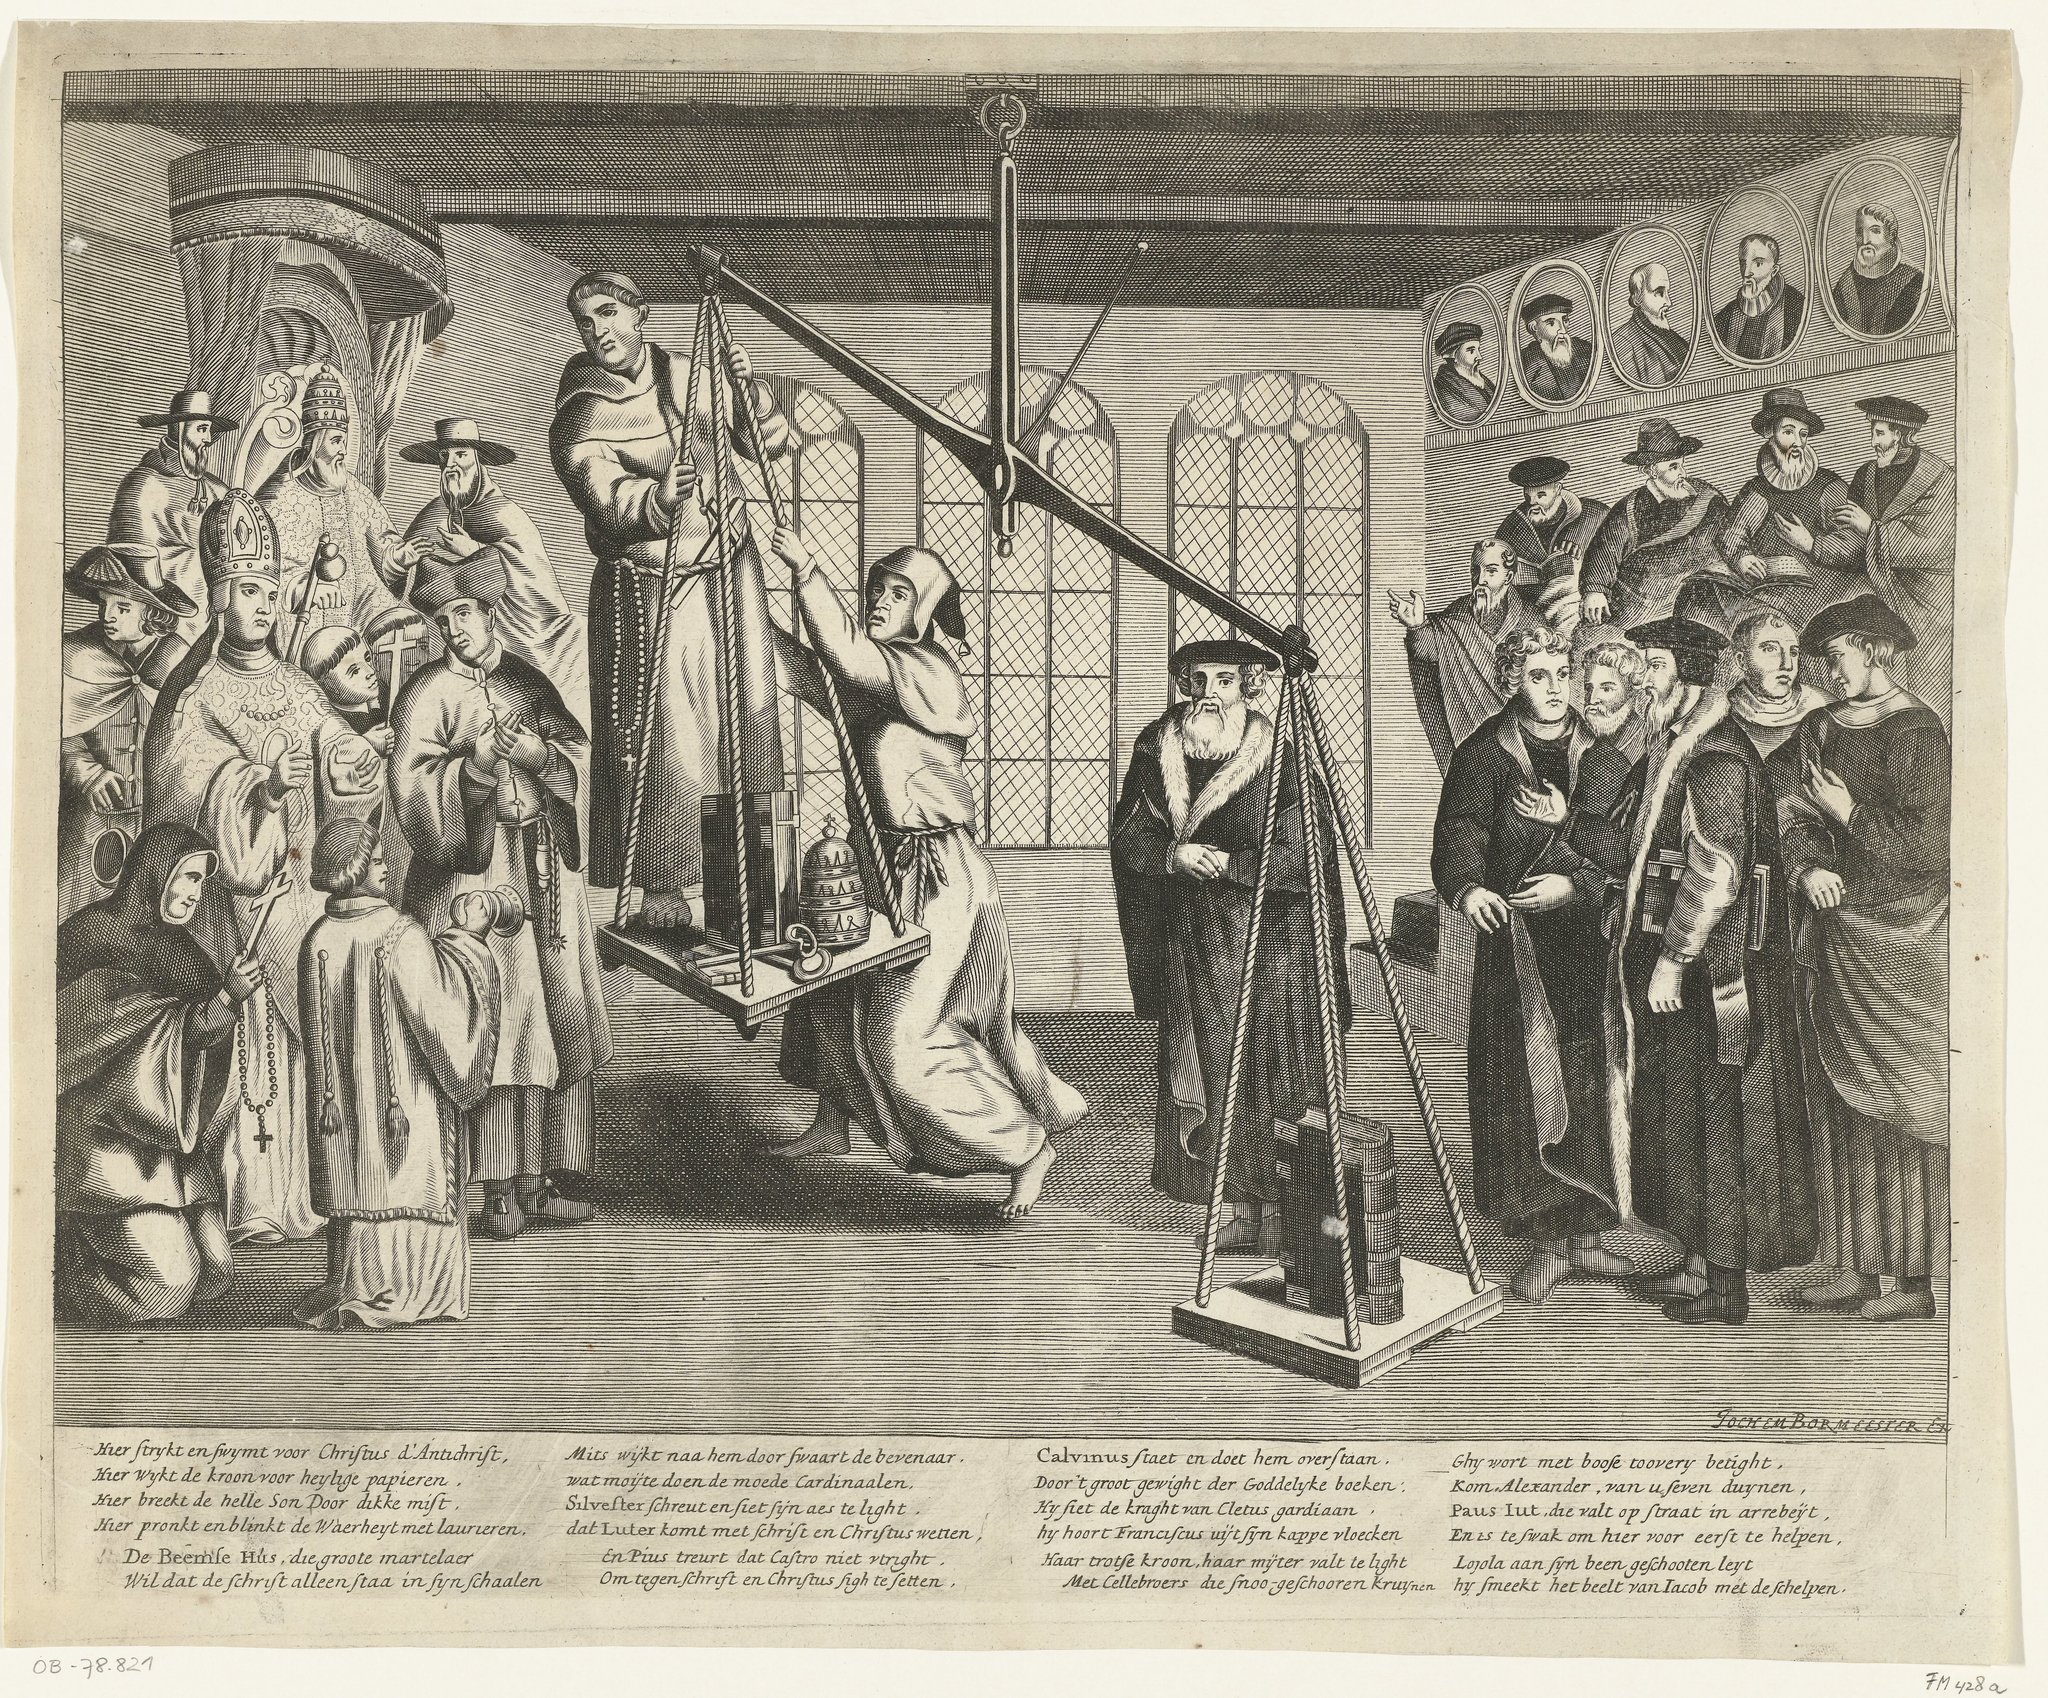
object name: print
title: De bijbel op de weegschaal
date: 1677-1690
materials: paper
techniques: engraving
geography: amsterdam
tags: priest, martin luther, reformation (roman catholic church vs. protestantism), scales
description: De bijbel op de weegschaal, ca. 1560. In een interieur wordt op een grote weegschaal de bijbel gewogen tegen het gewicht van de symbolen van de Roomse kerk. Aan de zijde van de bijbel, rechts, staat de groep kerkhervormers waaronder Jan Hus, Martin Luther en Johannes Calvijn. Links de vertegenwoordigers van de katholieke kerk: paus (Alexander?), kardinalen, bisschop, priester, non, misdienaar en pelgrim. Twee monniken proberen tevergeefs de weegschaal naar hun kant door te doen slaan. Met onderschrift van 4 kolommen met elk zes regels in het Nederlands. Spotprent op de Roomse Kerk, thematiek van ca. 1560.